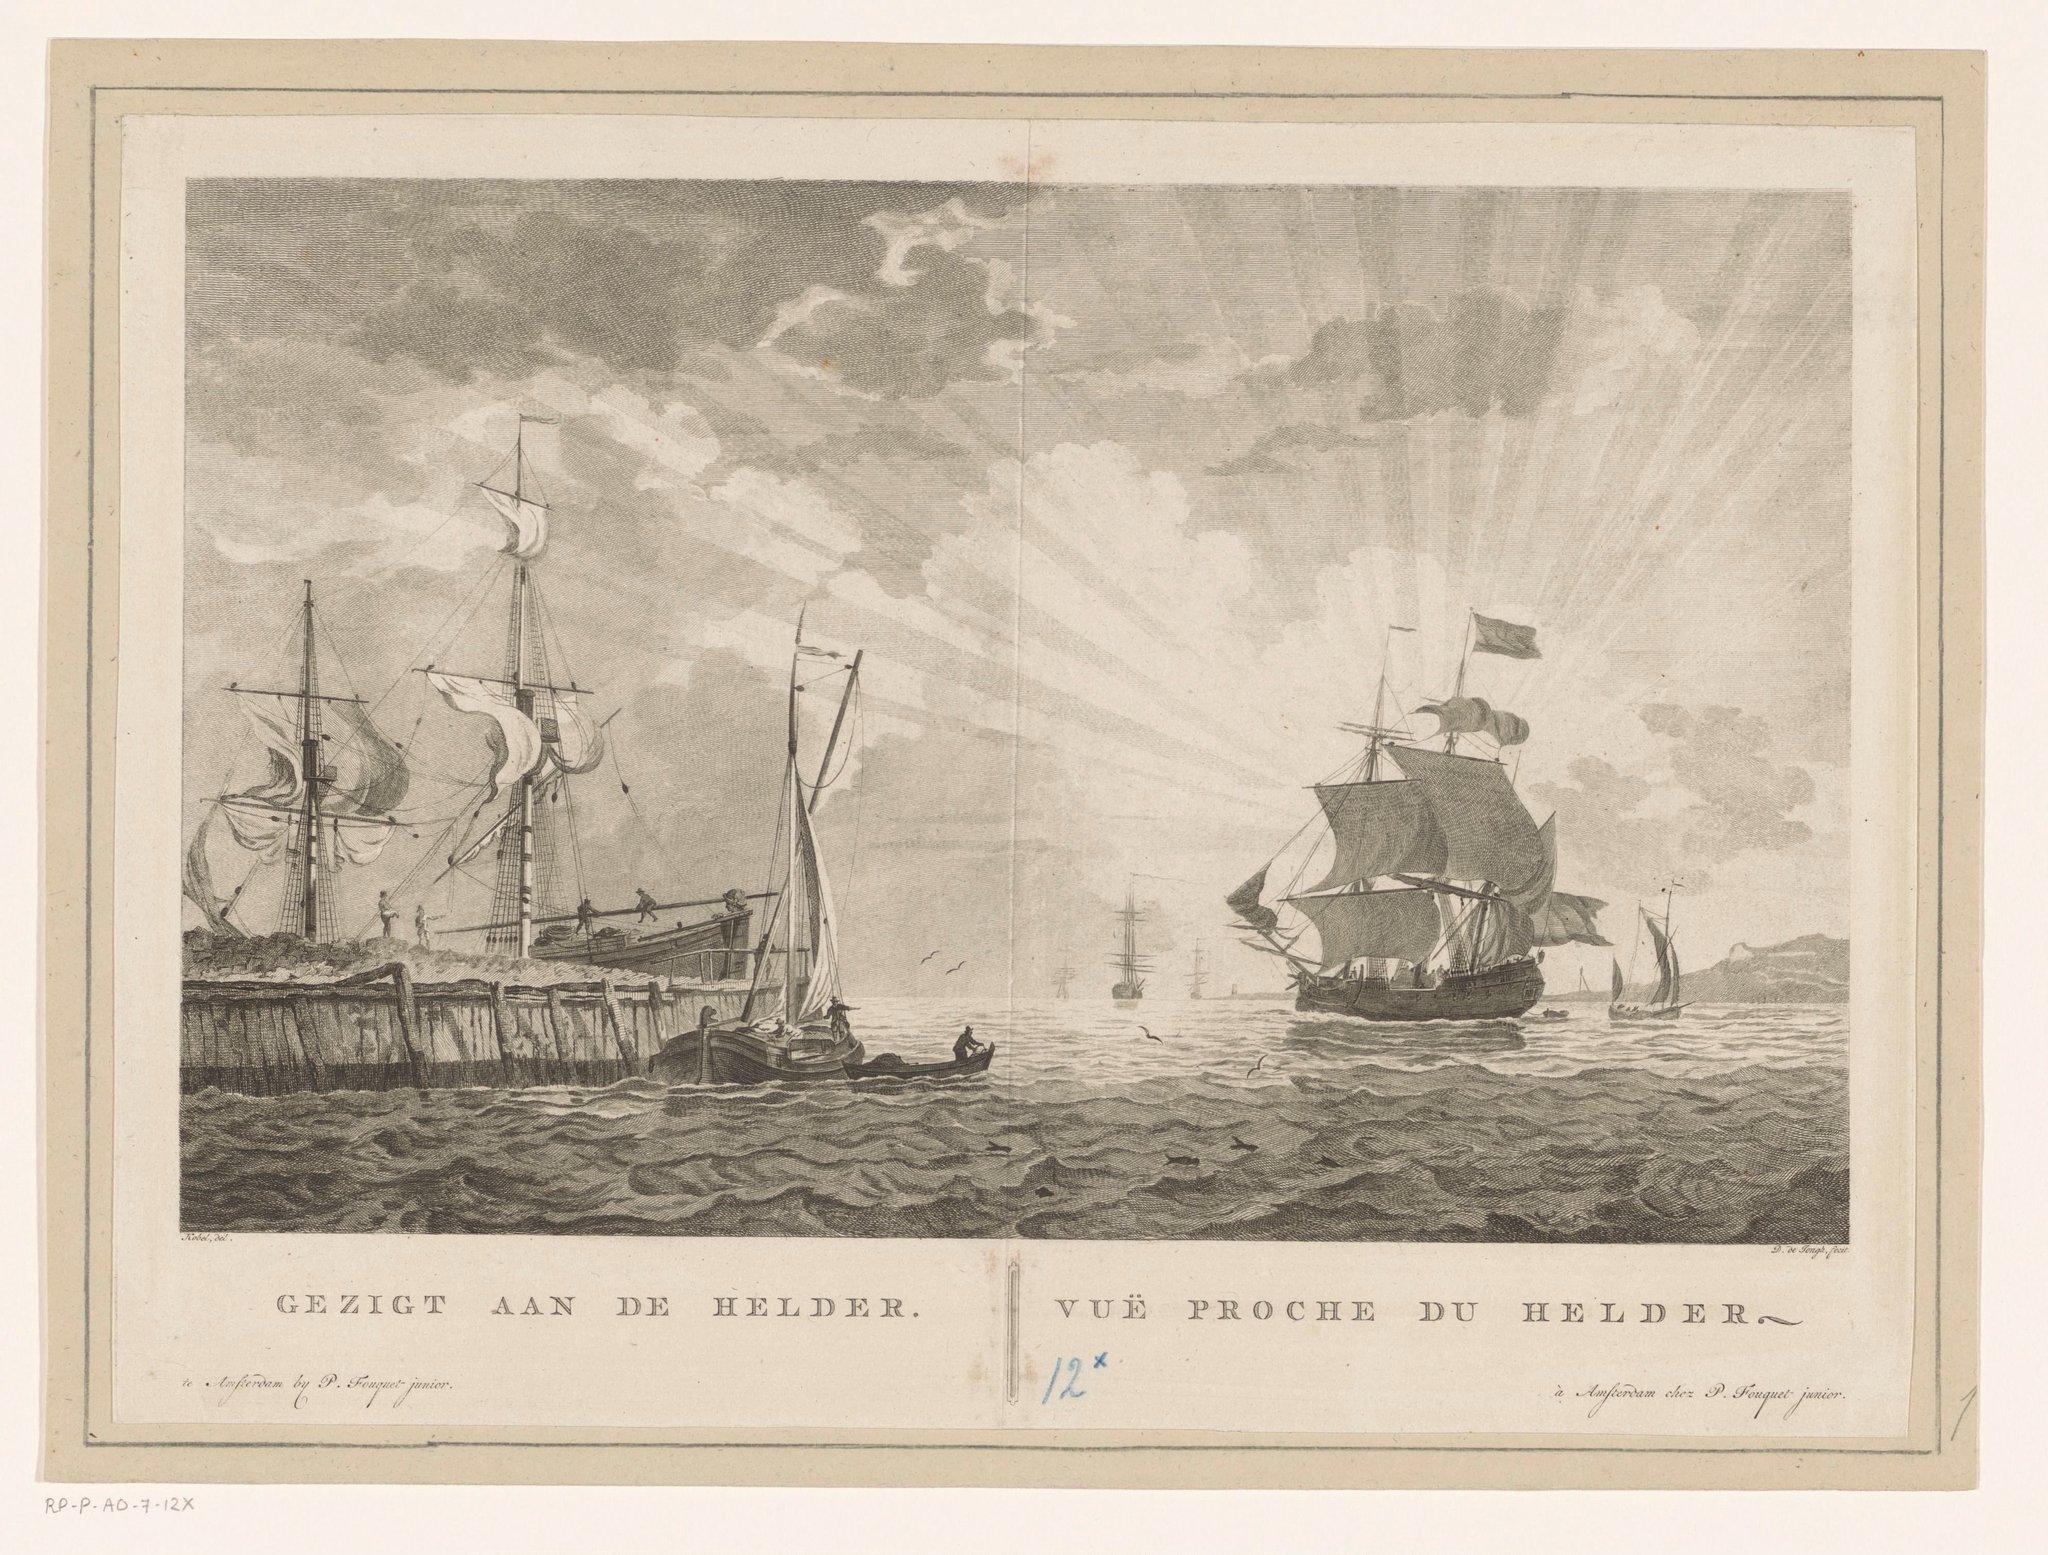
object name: print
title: Gezicht bij Den Helder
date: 1779-1796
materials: paper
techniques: engraving, etching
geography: rotterdam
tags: harbour, sailing-ship, sailing-boat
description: Latere staat ook gebruikt in: Aa, Cornelis van der. Atlas van de zeehavens der Bataafsche Republiek. Met derzelver beschrijvingen in XXXI kunstplaaten / Atlas van de zeehavens der Bataafsche Republiek, die van Batavia en Onrust. Mitsgaders de afbeeldingen van de haringvisscherij en de walvischvangst (…). Amsterdam: Evert Maaskamp, 1805.